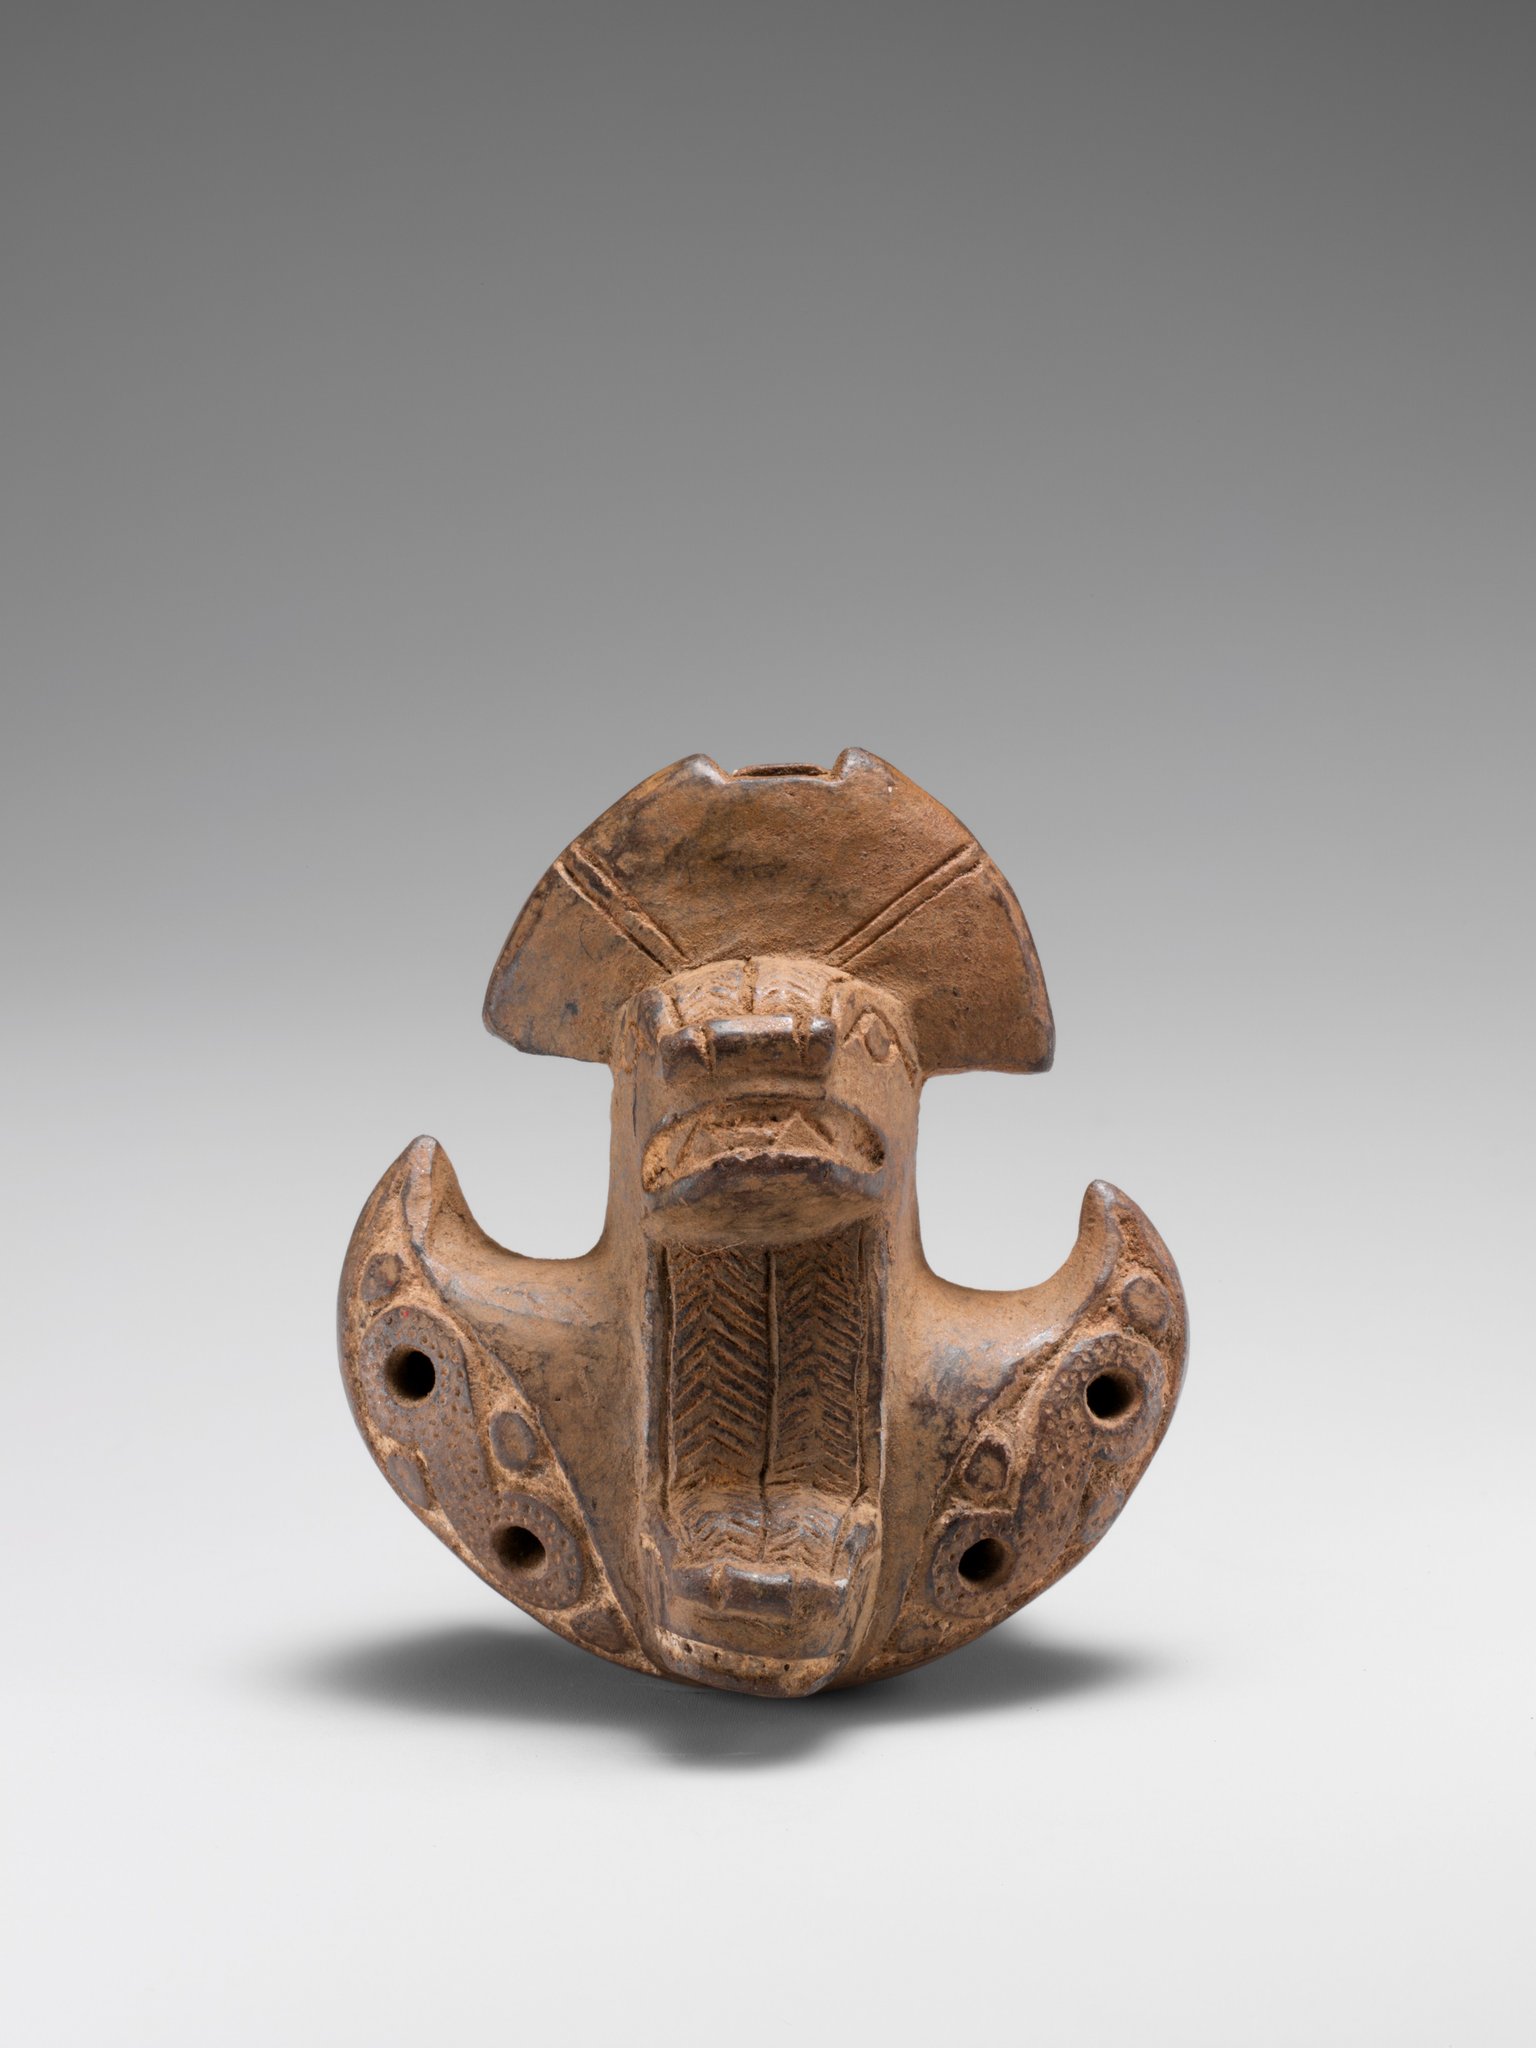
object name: ocarina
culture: tairona people or la aguja style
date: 1300-1500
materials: ceramic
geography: colombia